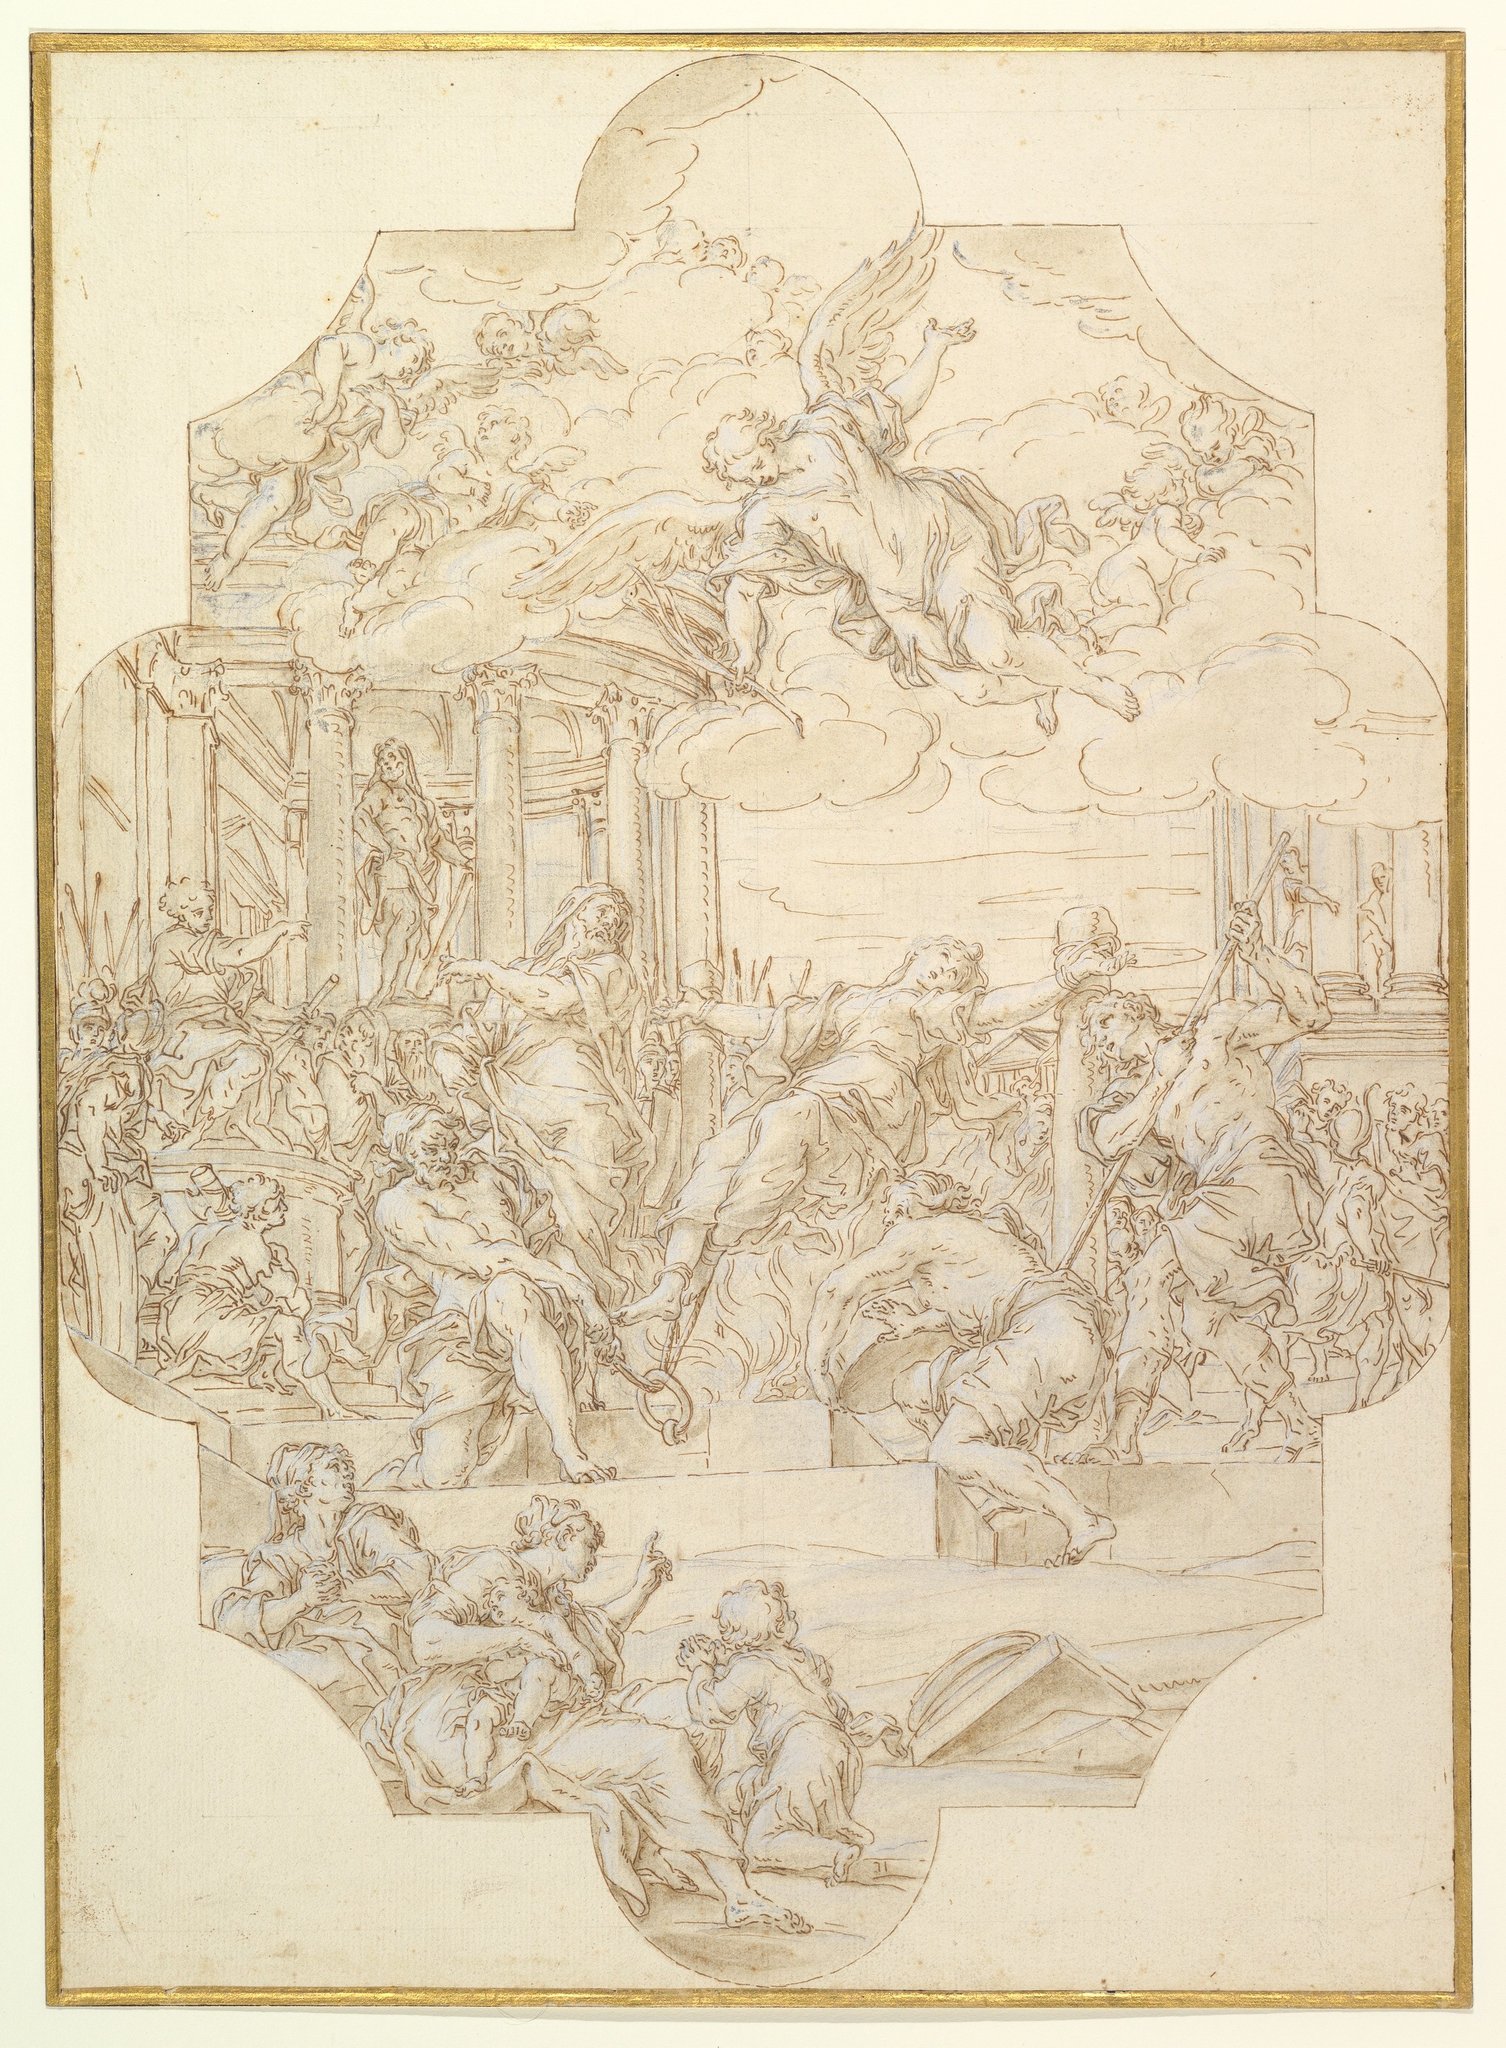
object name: drawing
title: The Martyrdom of Saint Anastasia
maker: michelangelo cerruti ("il candelottaro")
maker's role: artist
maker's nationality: italian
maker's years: 1663-1748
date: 1721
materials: chalk, gouache, ink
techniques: brush, highlighting, pen, wash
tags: men,women,angels,saints